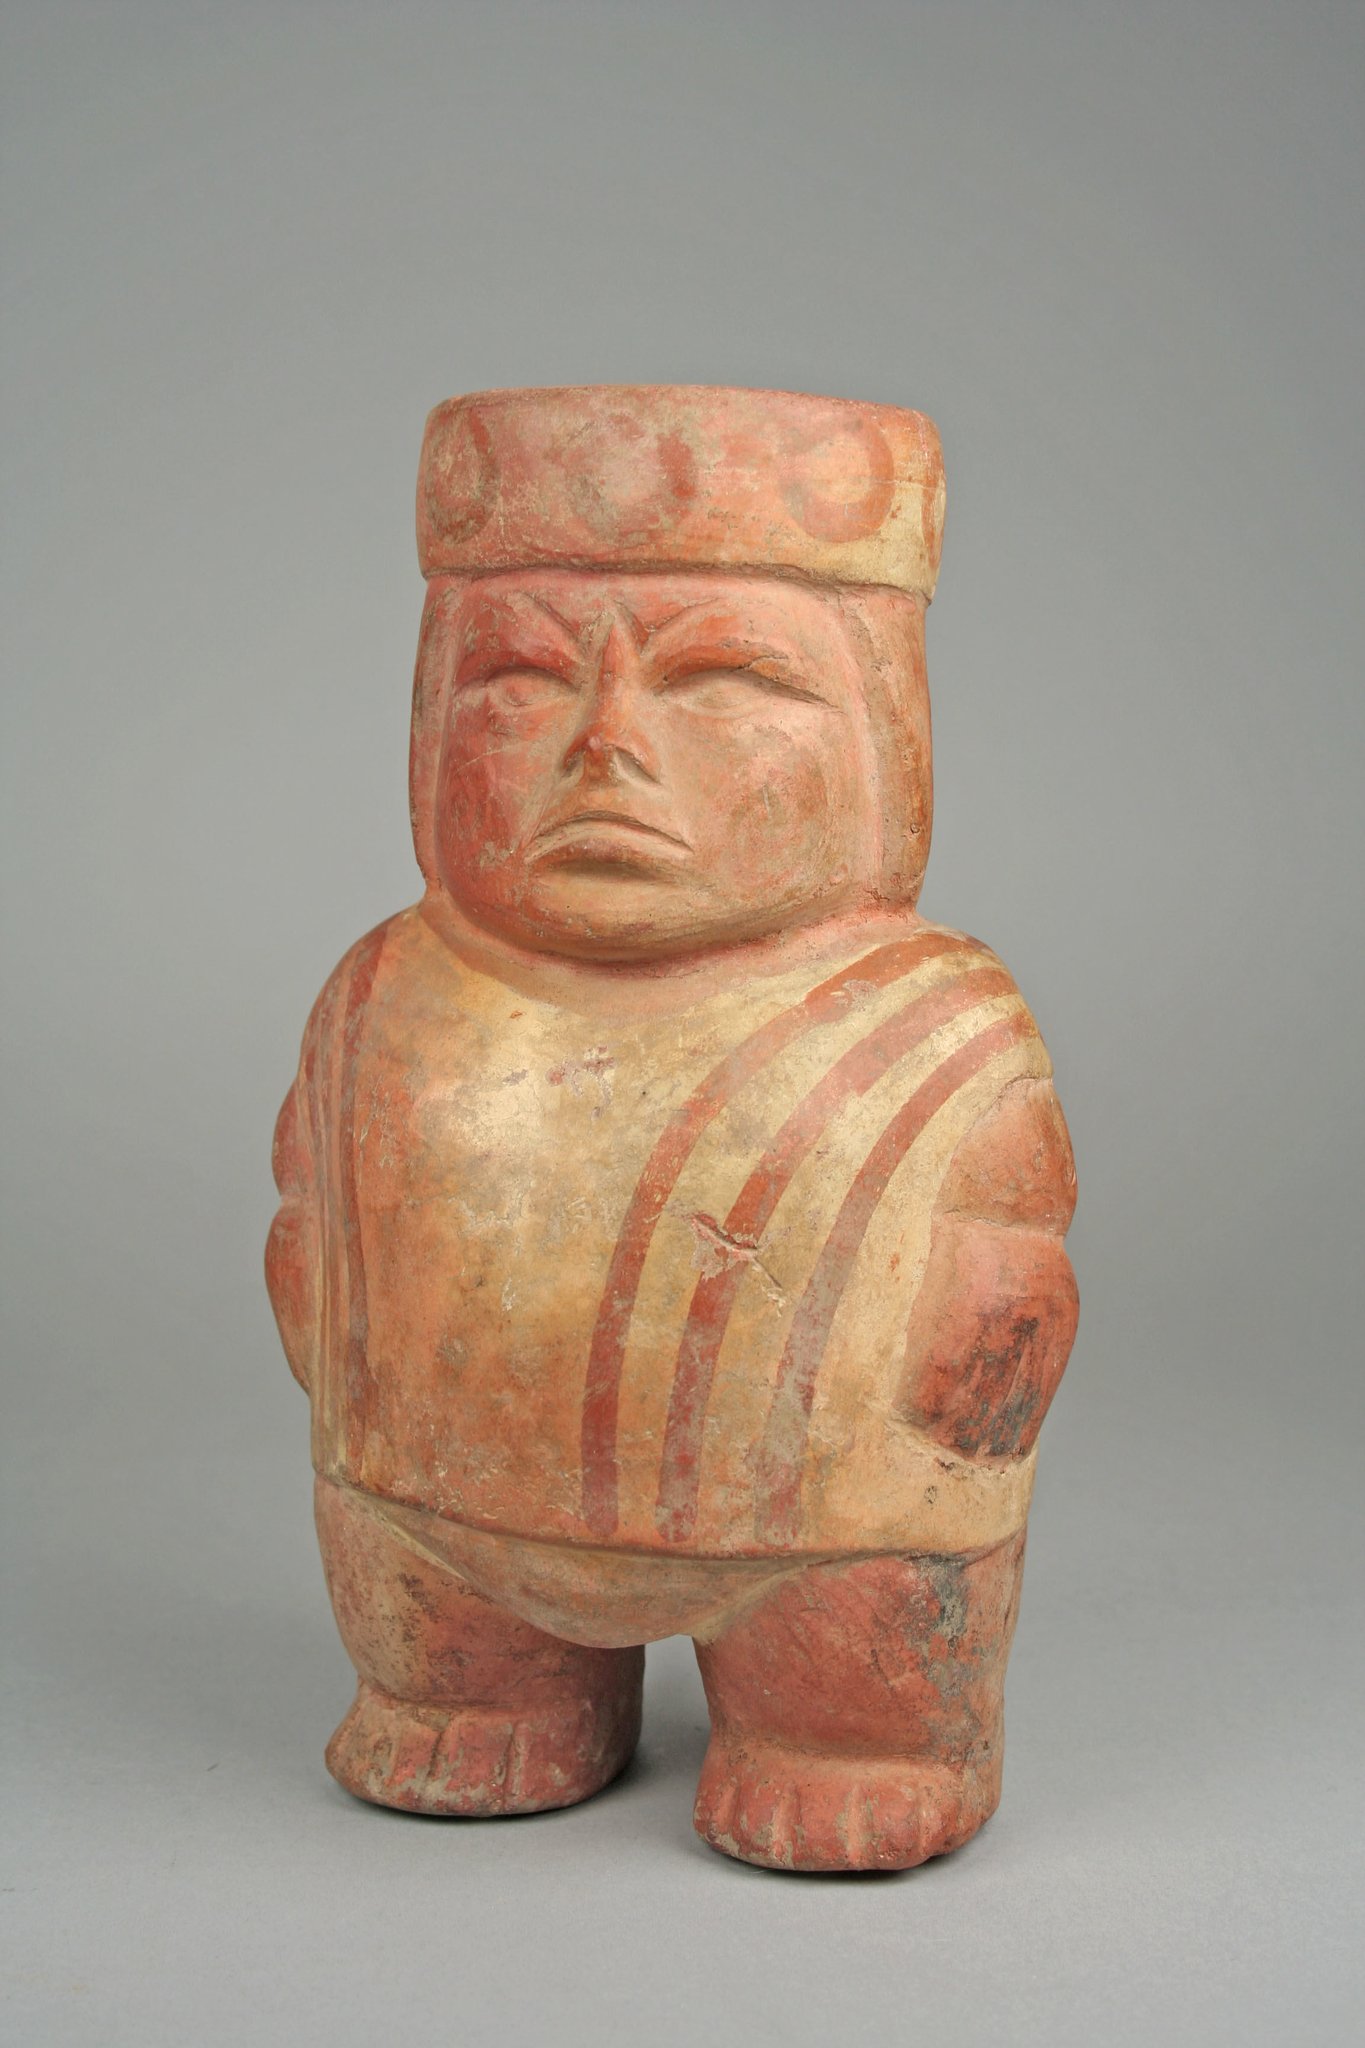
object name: bottle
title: Jar, Fat Figure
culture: moche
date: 201-600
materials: ceramic, pigment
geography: peru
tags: human figures